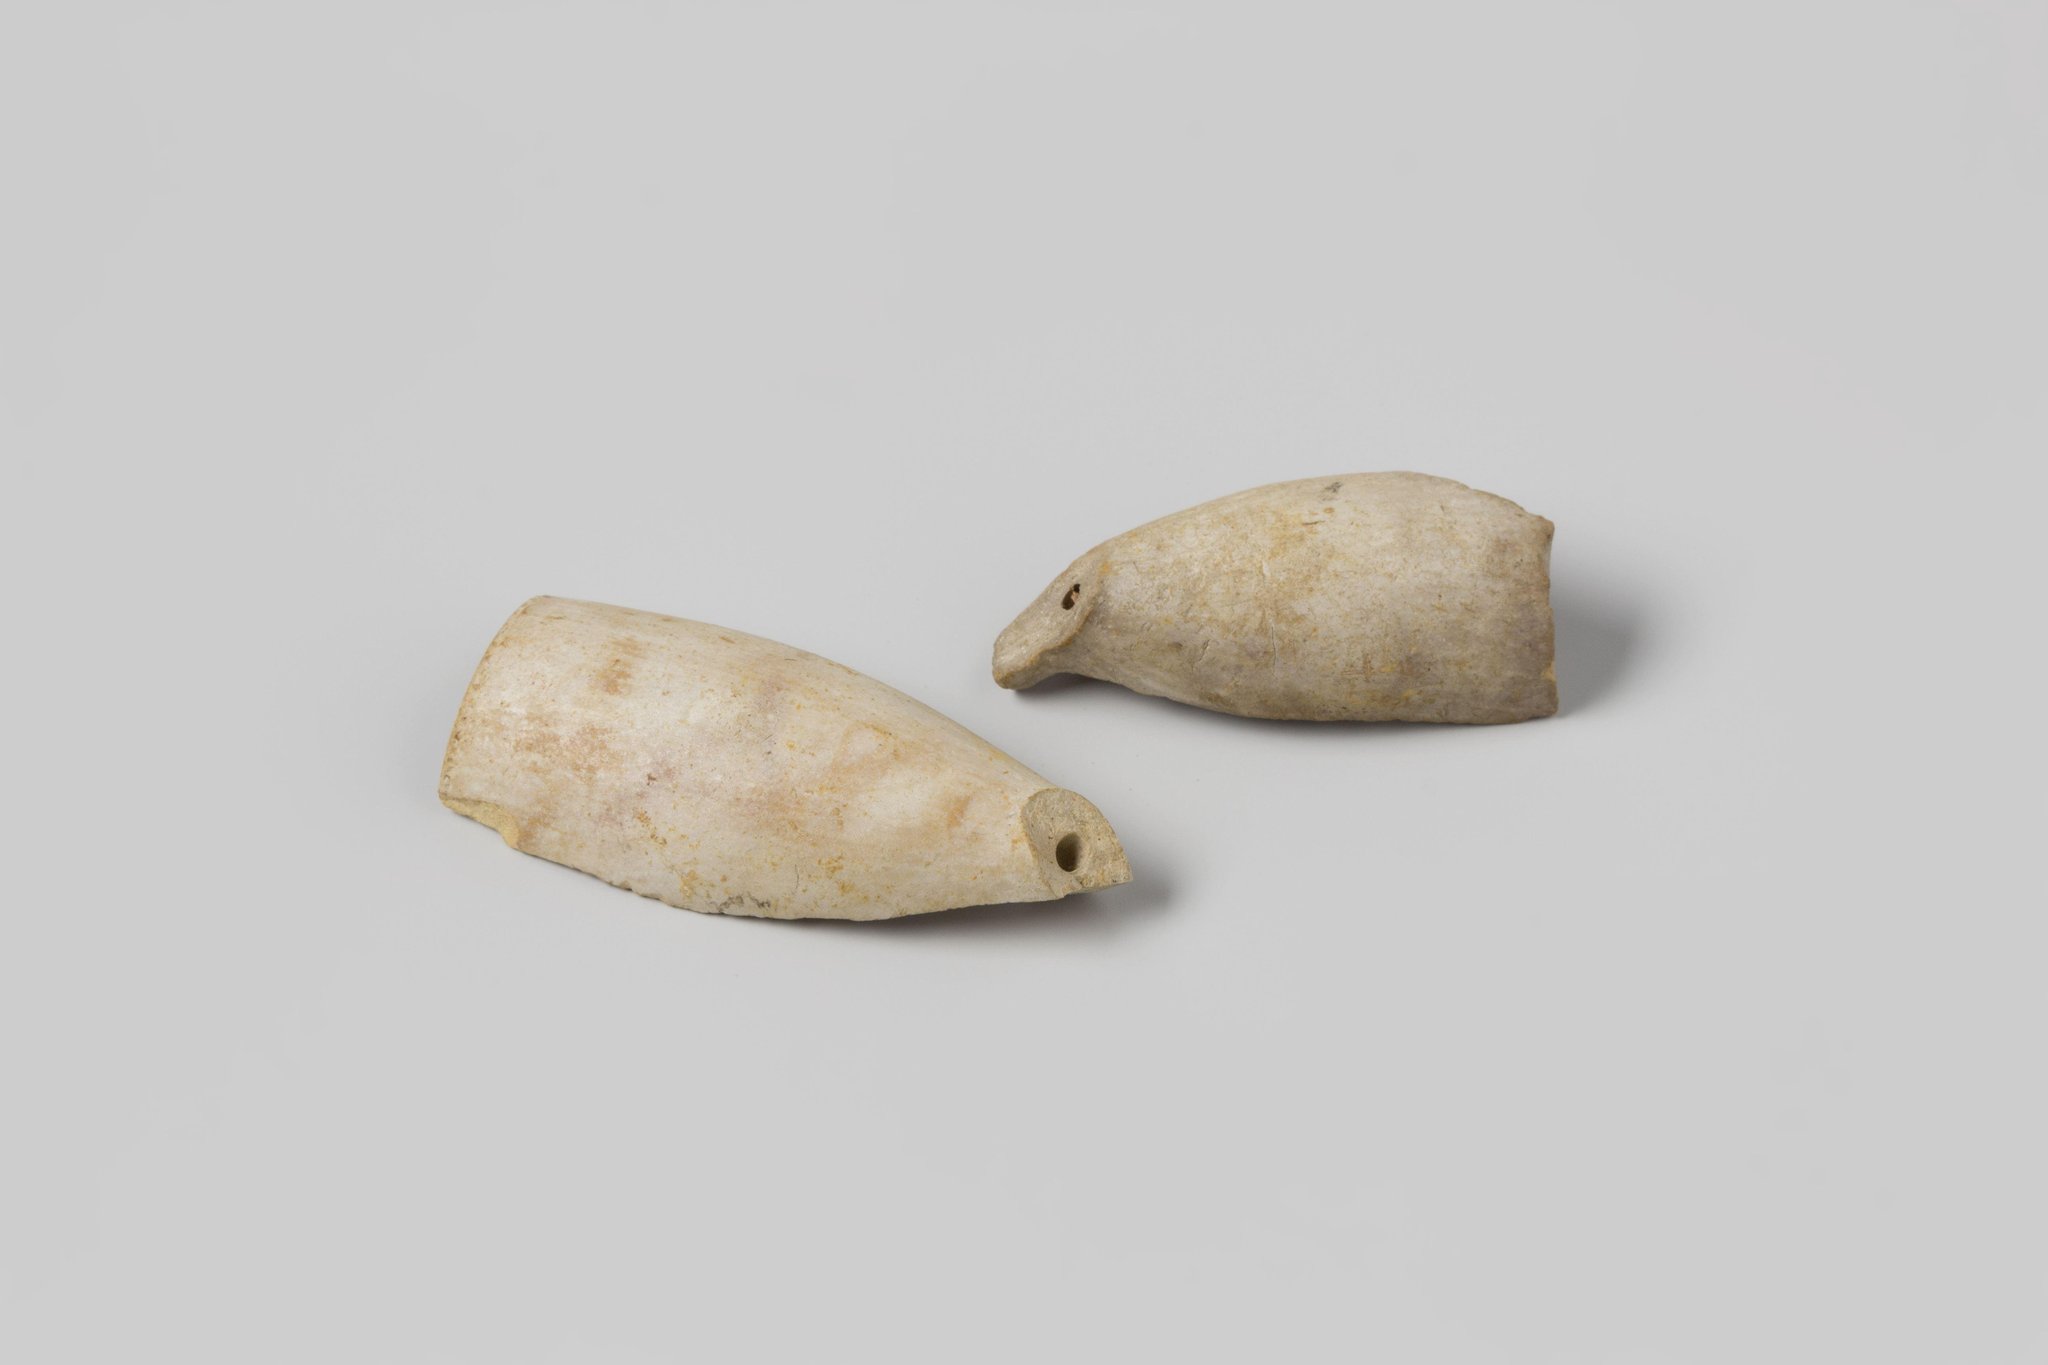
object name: pipe bowl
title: Fragmenten pijpenkoppen uit het wrak van de Oost-Indiëvaarder Hollandia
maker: Anonymous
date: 1700-1743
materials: clay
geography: netherlands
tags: verenigde oostindische compagnie, hollandia (schip), annet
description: Pipe, bowl, heelmark illegible; fragments.